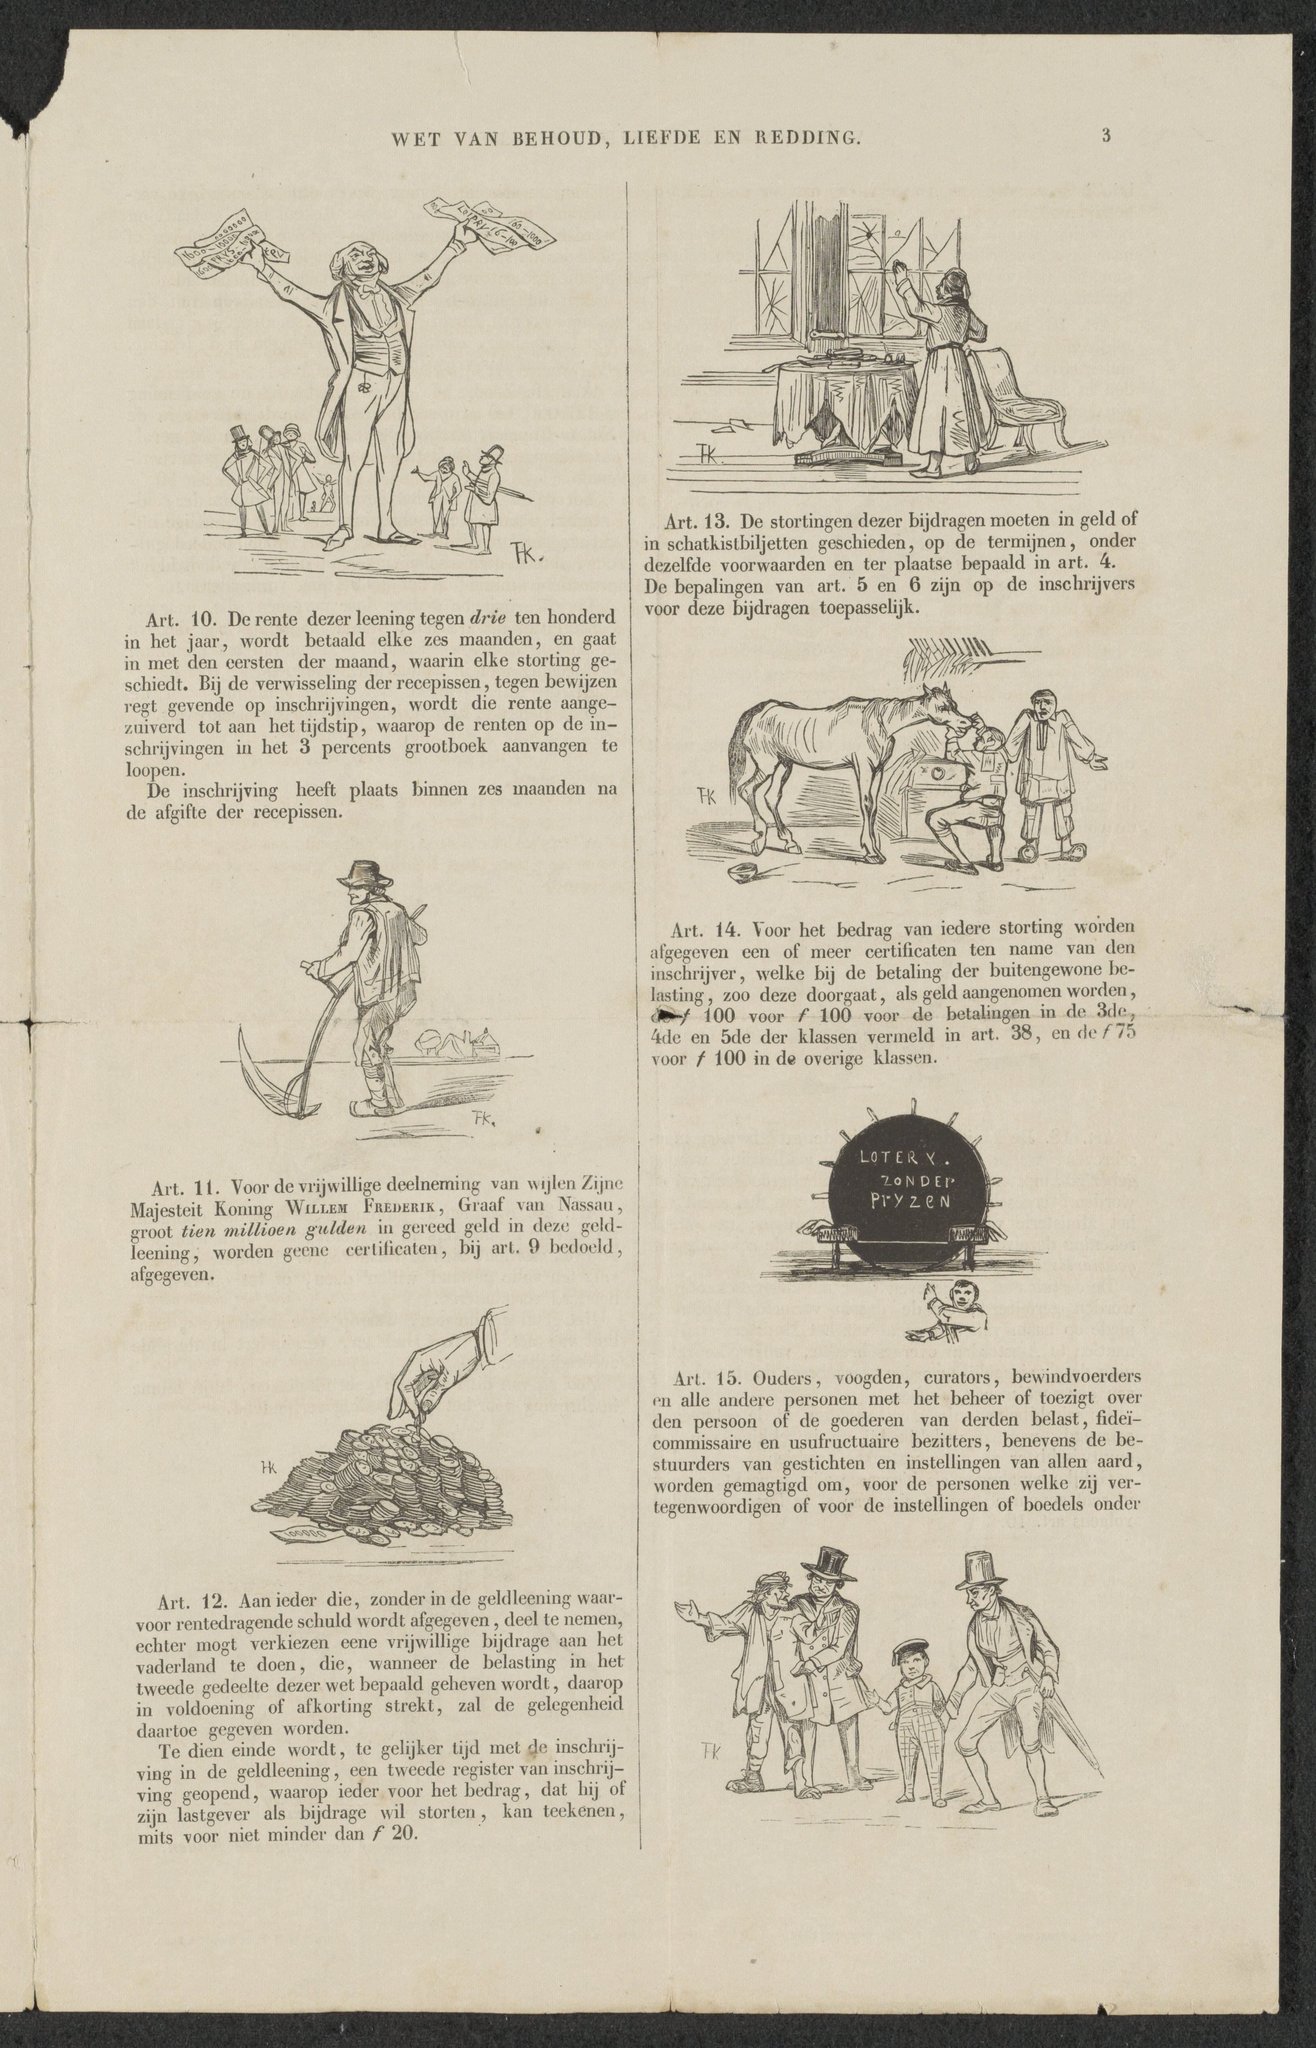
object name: print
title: Vermeerderd, Verbeterd en de Volmaaktheid Overtreffend Nieuw Ontwerp van Wet van Behoud, Liefde en Redding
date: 1844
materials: paper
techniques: letterpress printing, engraving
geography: the hague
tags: floris adriaan van hall, organization of trade and finance, taxes and financial administration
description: Bladzijde 3 met artikels 10-15 van het 'Vermeerderd, Verbeterd en de Volmaaktheid Overtreffend Nieuw Ontwerp van Wet van Behoud, Liefde en Redding'. Een enigszins aaangepaste herdruk van satire in zestien bladzijden op de aansporing tot deelneming in de (zogenaamde) vrijwillige 3% geldlening uitgeschreven in maart 1844 door minister F.A. van Hall. Binnenzijde van een dubbelgevouwen blad bedrukt op alle zijden.